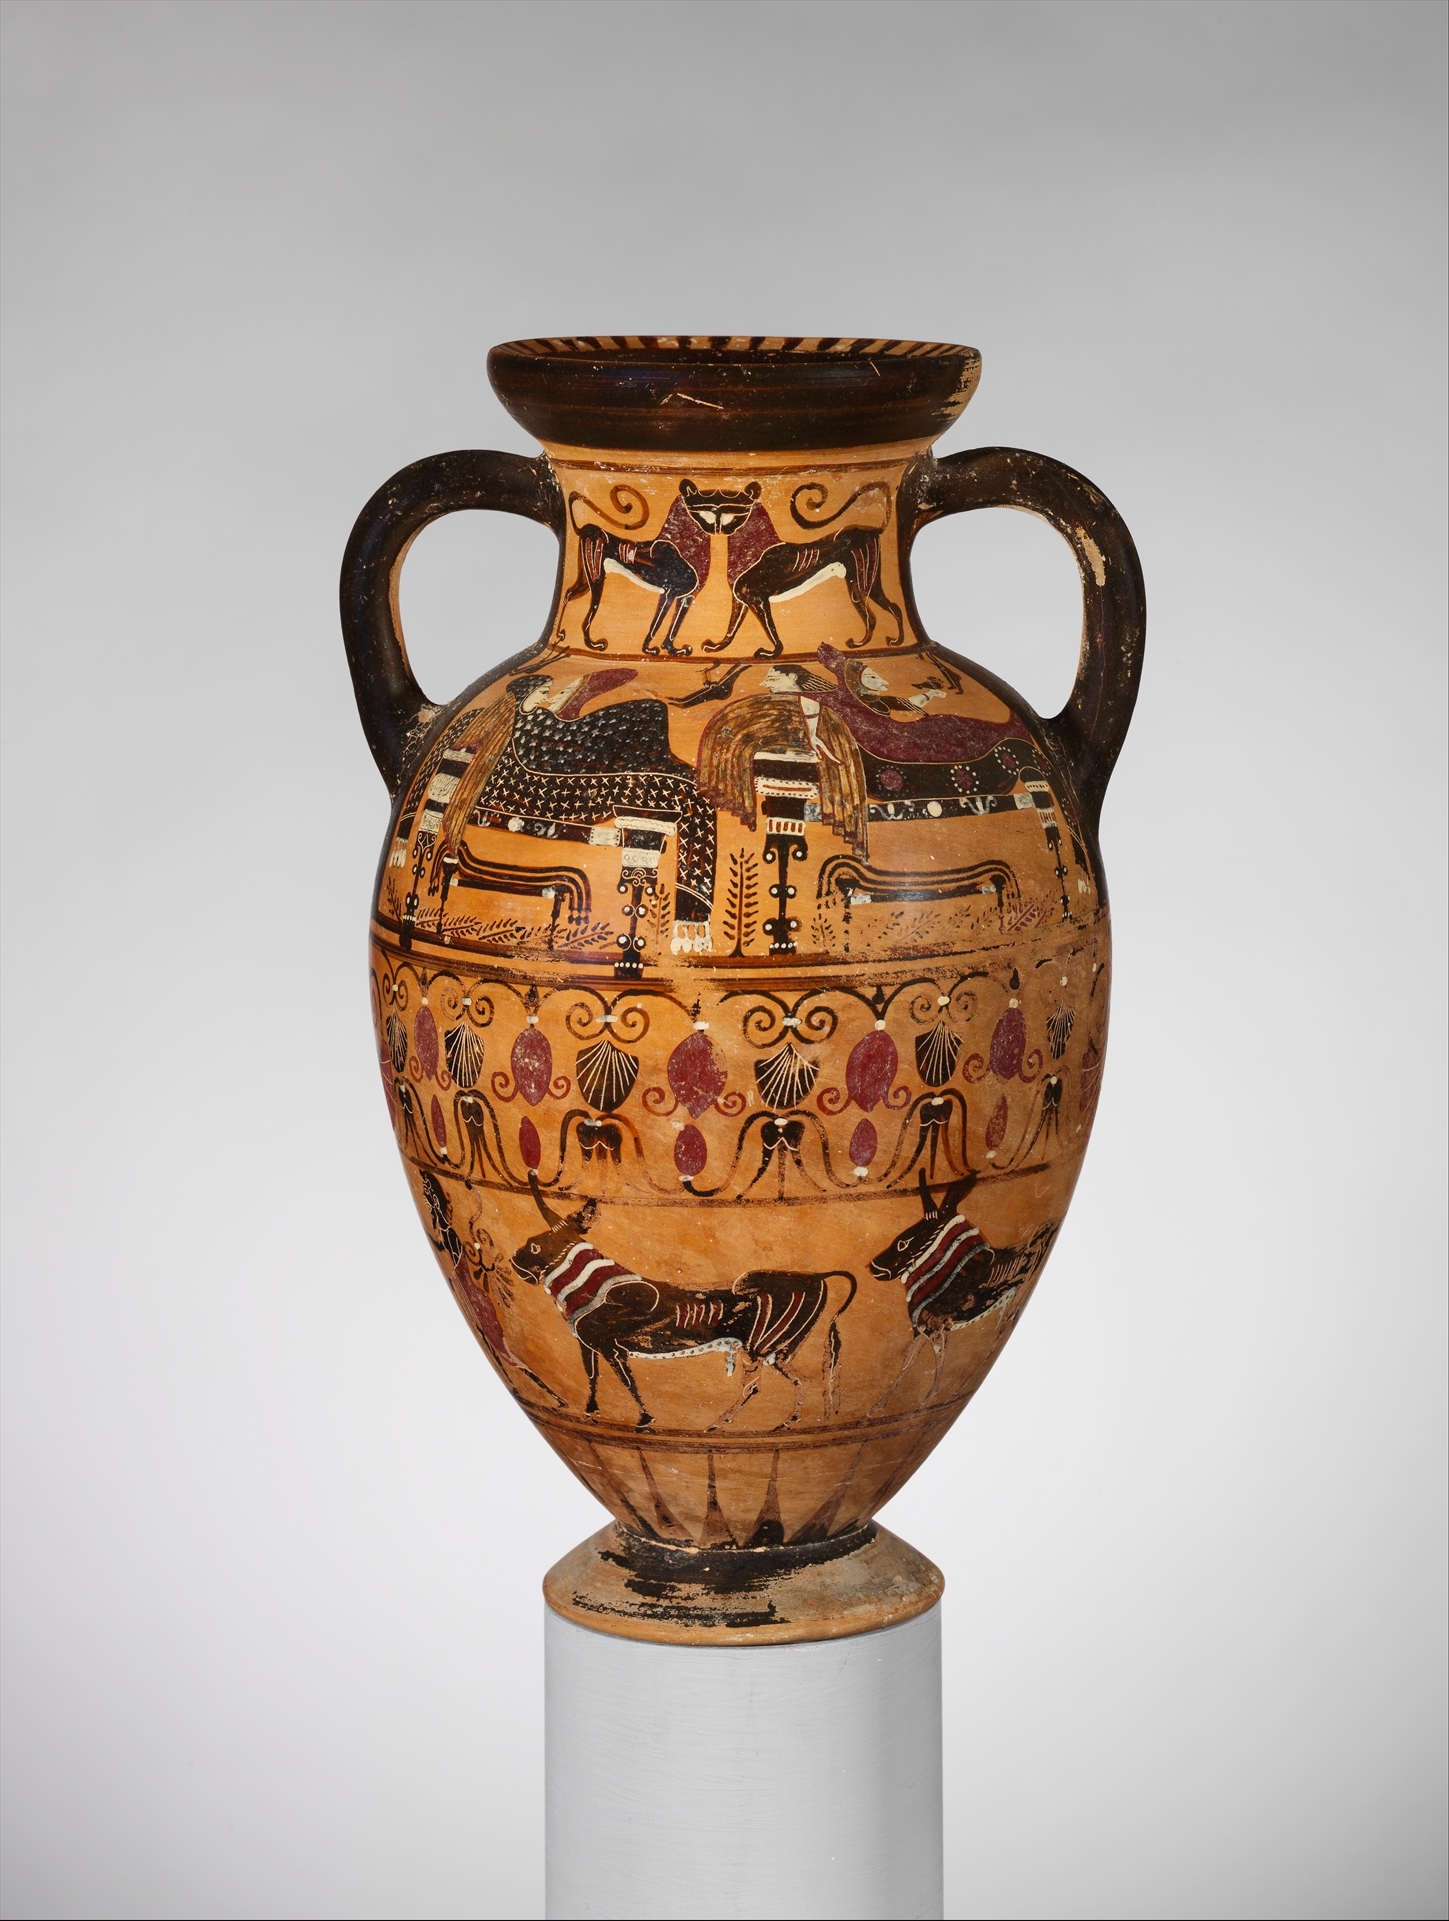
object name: neck amphora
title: Terracotta neck-amphora (jar)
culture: etruscan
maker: paris painter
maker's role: artist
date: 540 BCE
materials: terracotta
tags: men,women,centaurs,bulls,panthers